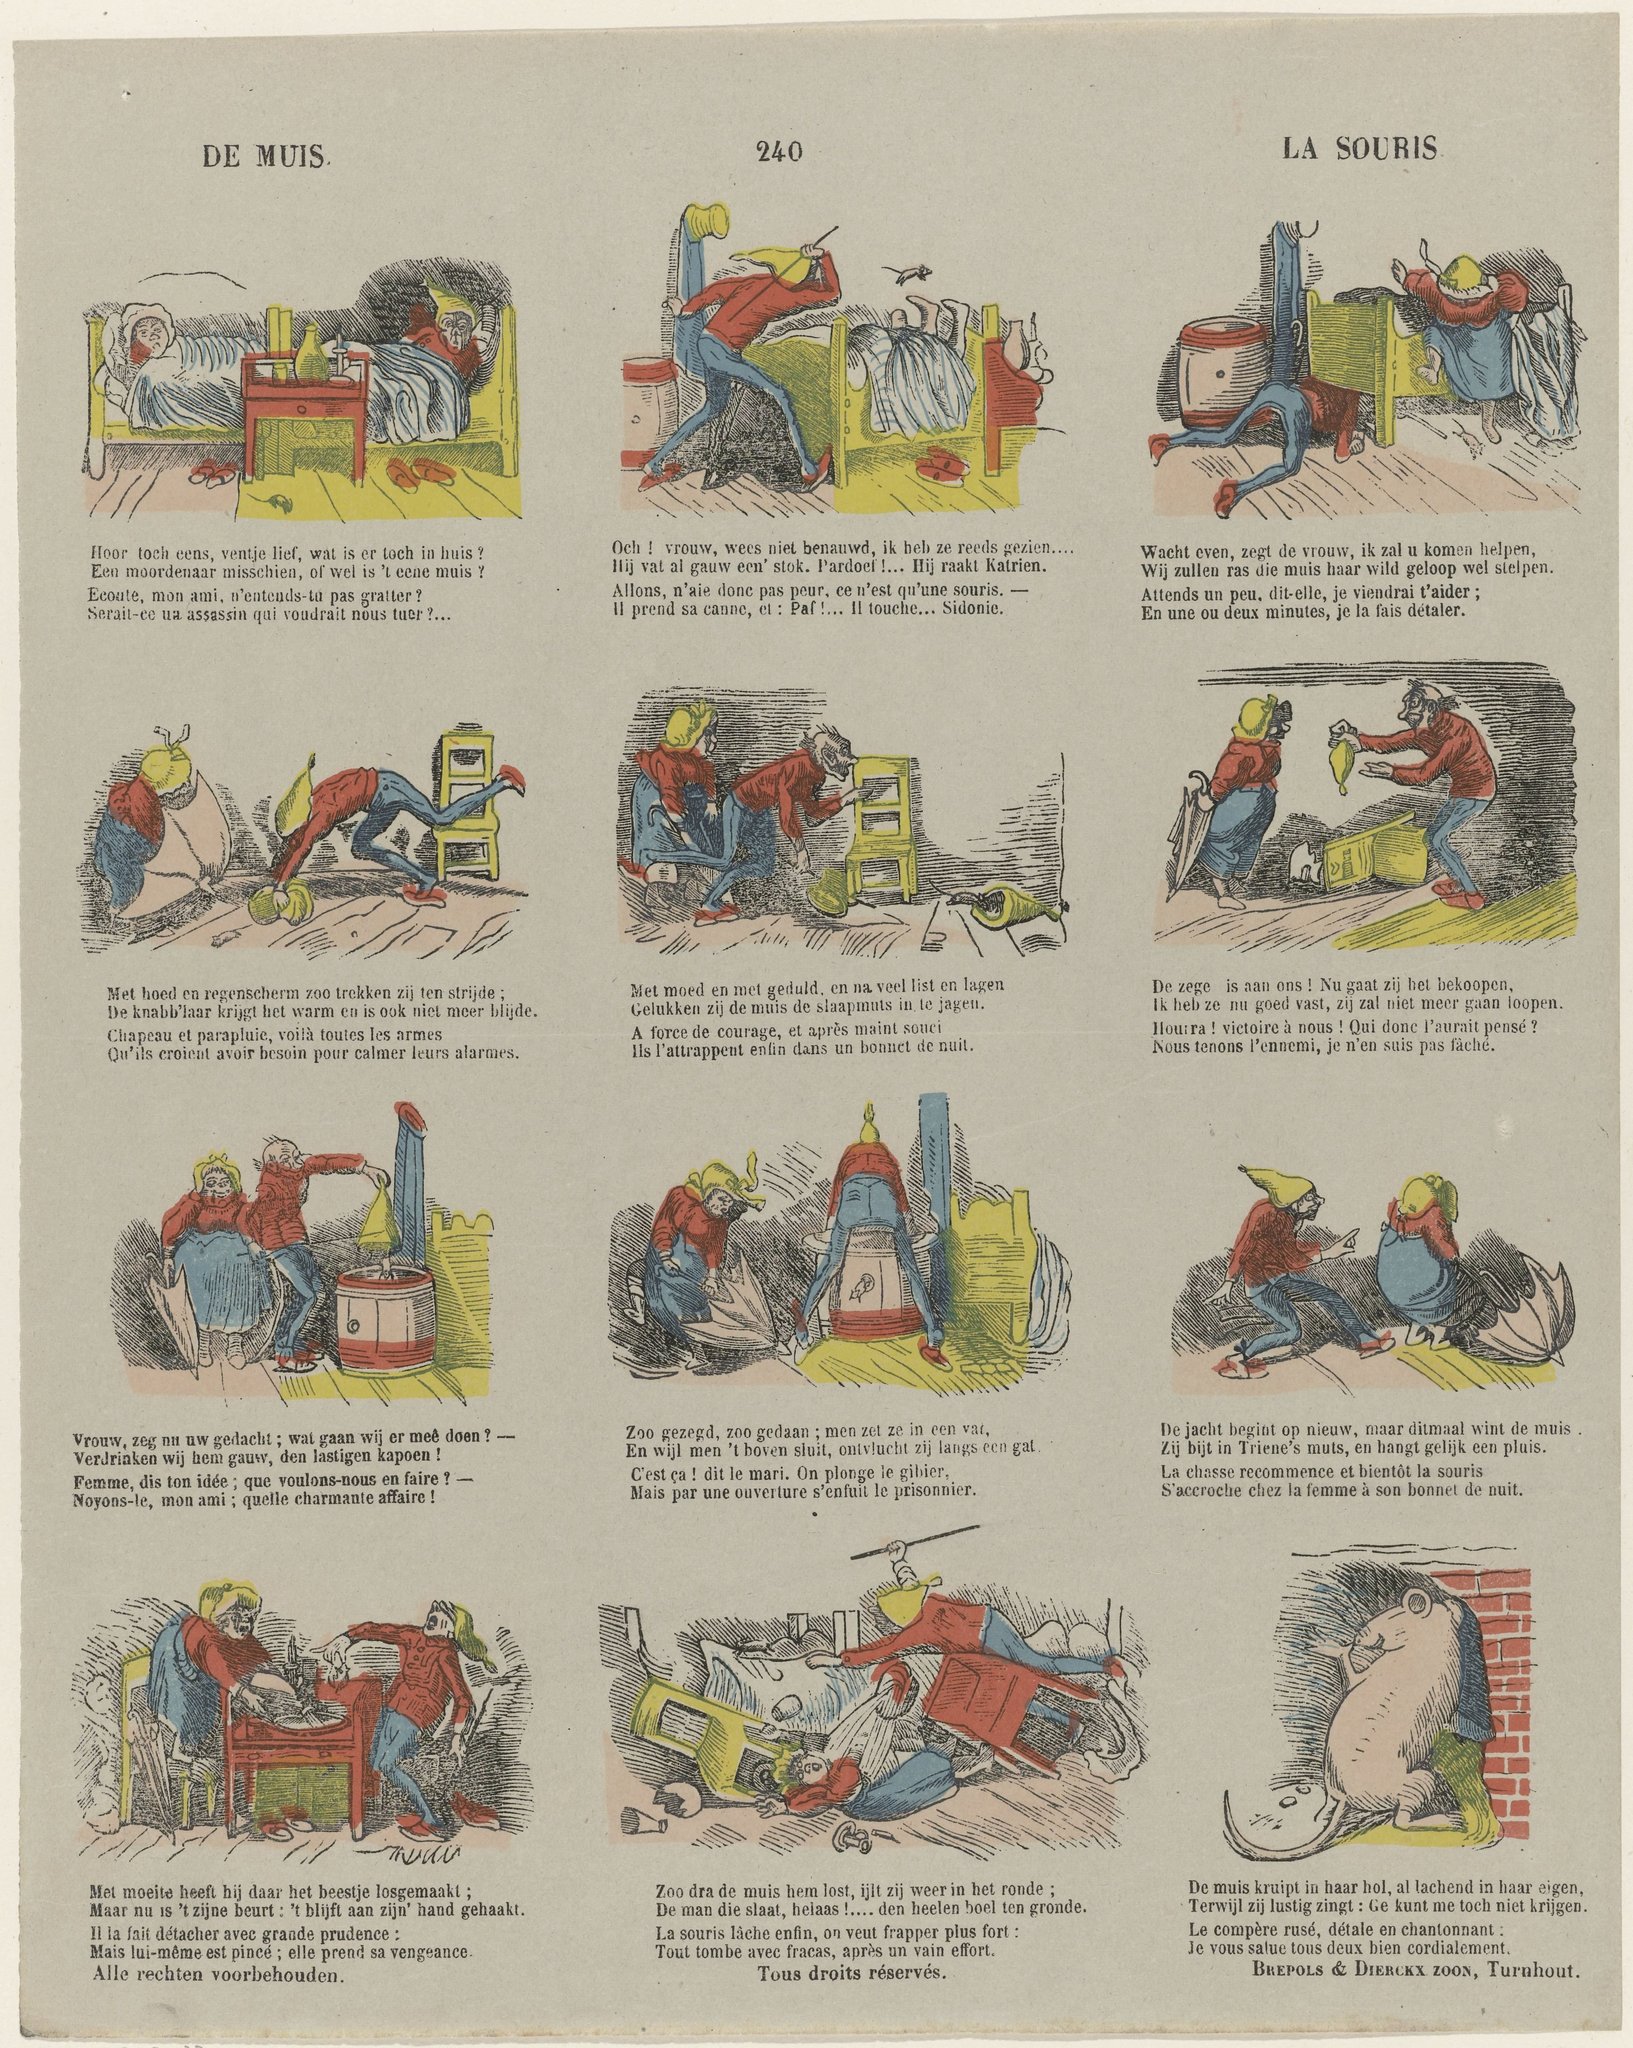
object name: print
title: De muis / La souris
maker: Anonymous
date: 1833-1911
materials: paper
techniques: lithograph, letterpress printing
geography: turnhout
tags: rodents: mouse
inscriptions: collector's mark: Lugt 2760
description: Blad met 12 voorstellingen over een man en vrouw die een muis in hun huis proberen te vangen. Onder elke afbeelding een onderschrift in het Nederlands en in het Frans. Genummerd midden boven: 240.